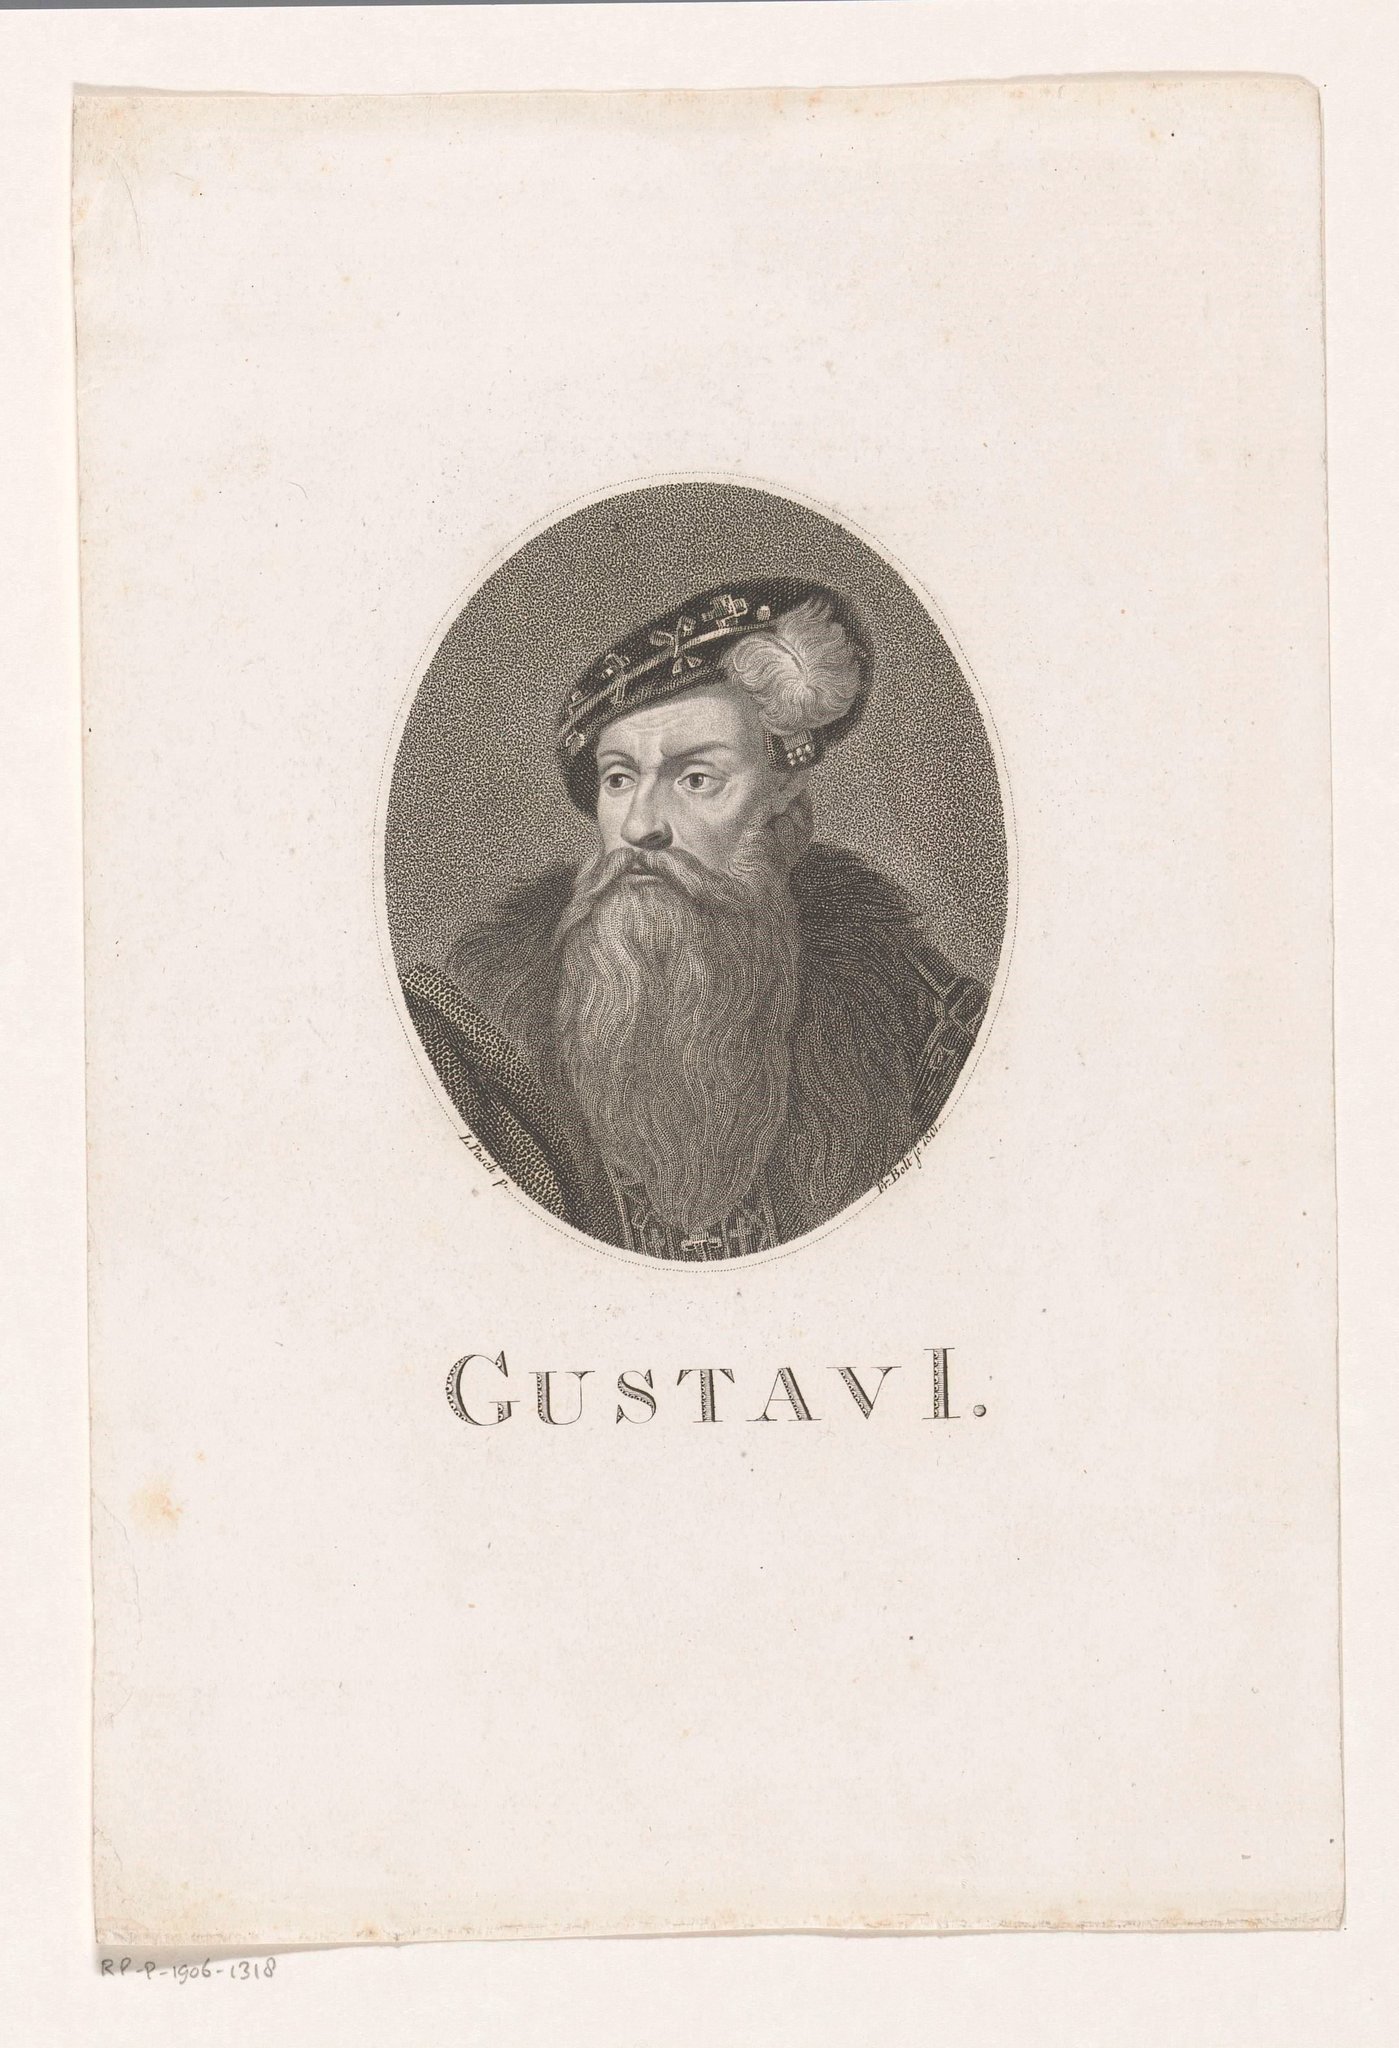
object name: print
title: Portret van Gustaaf I, koning van Zweden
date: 1801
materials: paper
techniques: stippling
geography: berlin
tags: historical persons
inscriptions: collector's mark: Lugt 2228